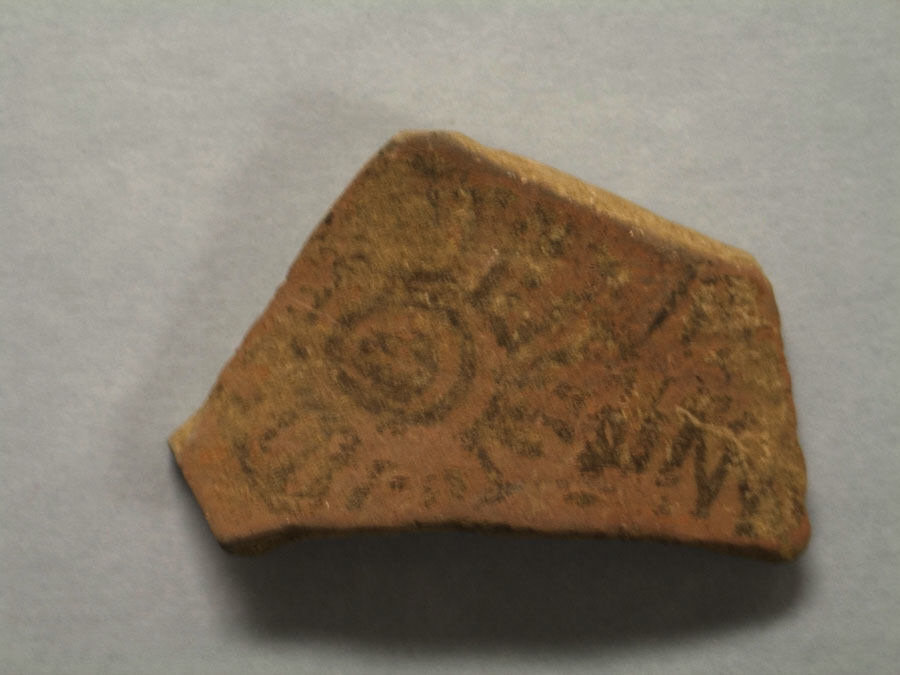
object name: shard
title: Shard: Flower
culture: pakistani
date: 301-500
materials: terracotta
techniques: painting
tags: gandhara